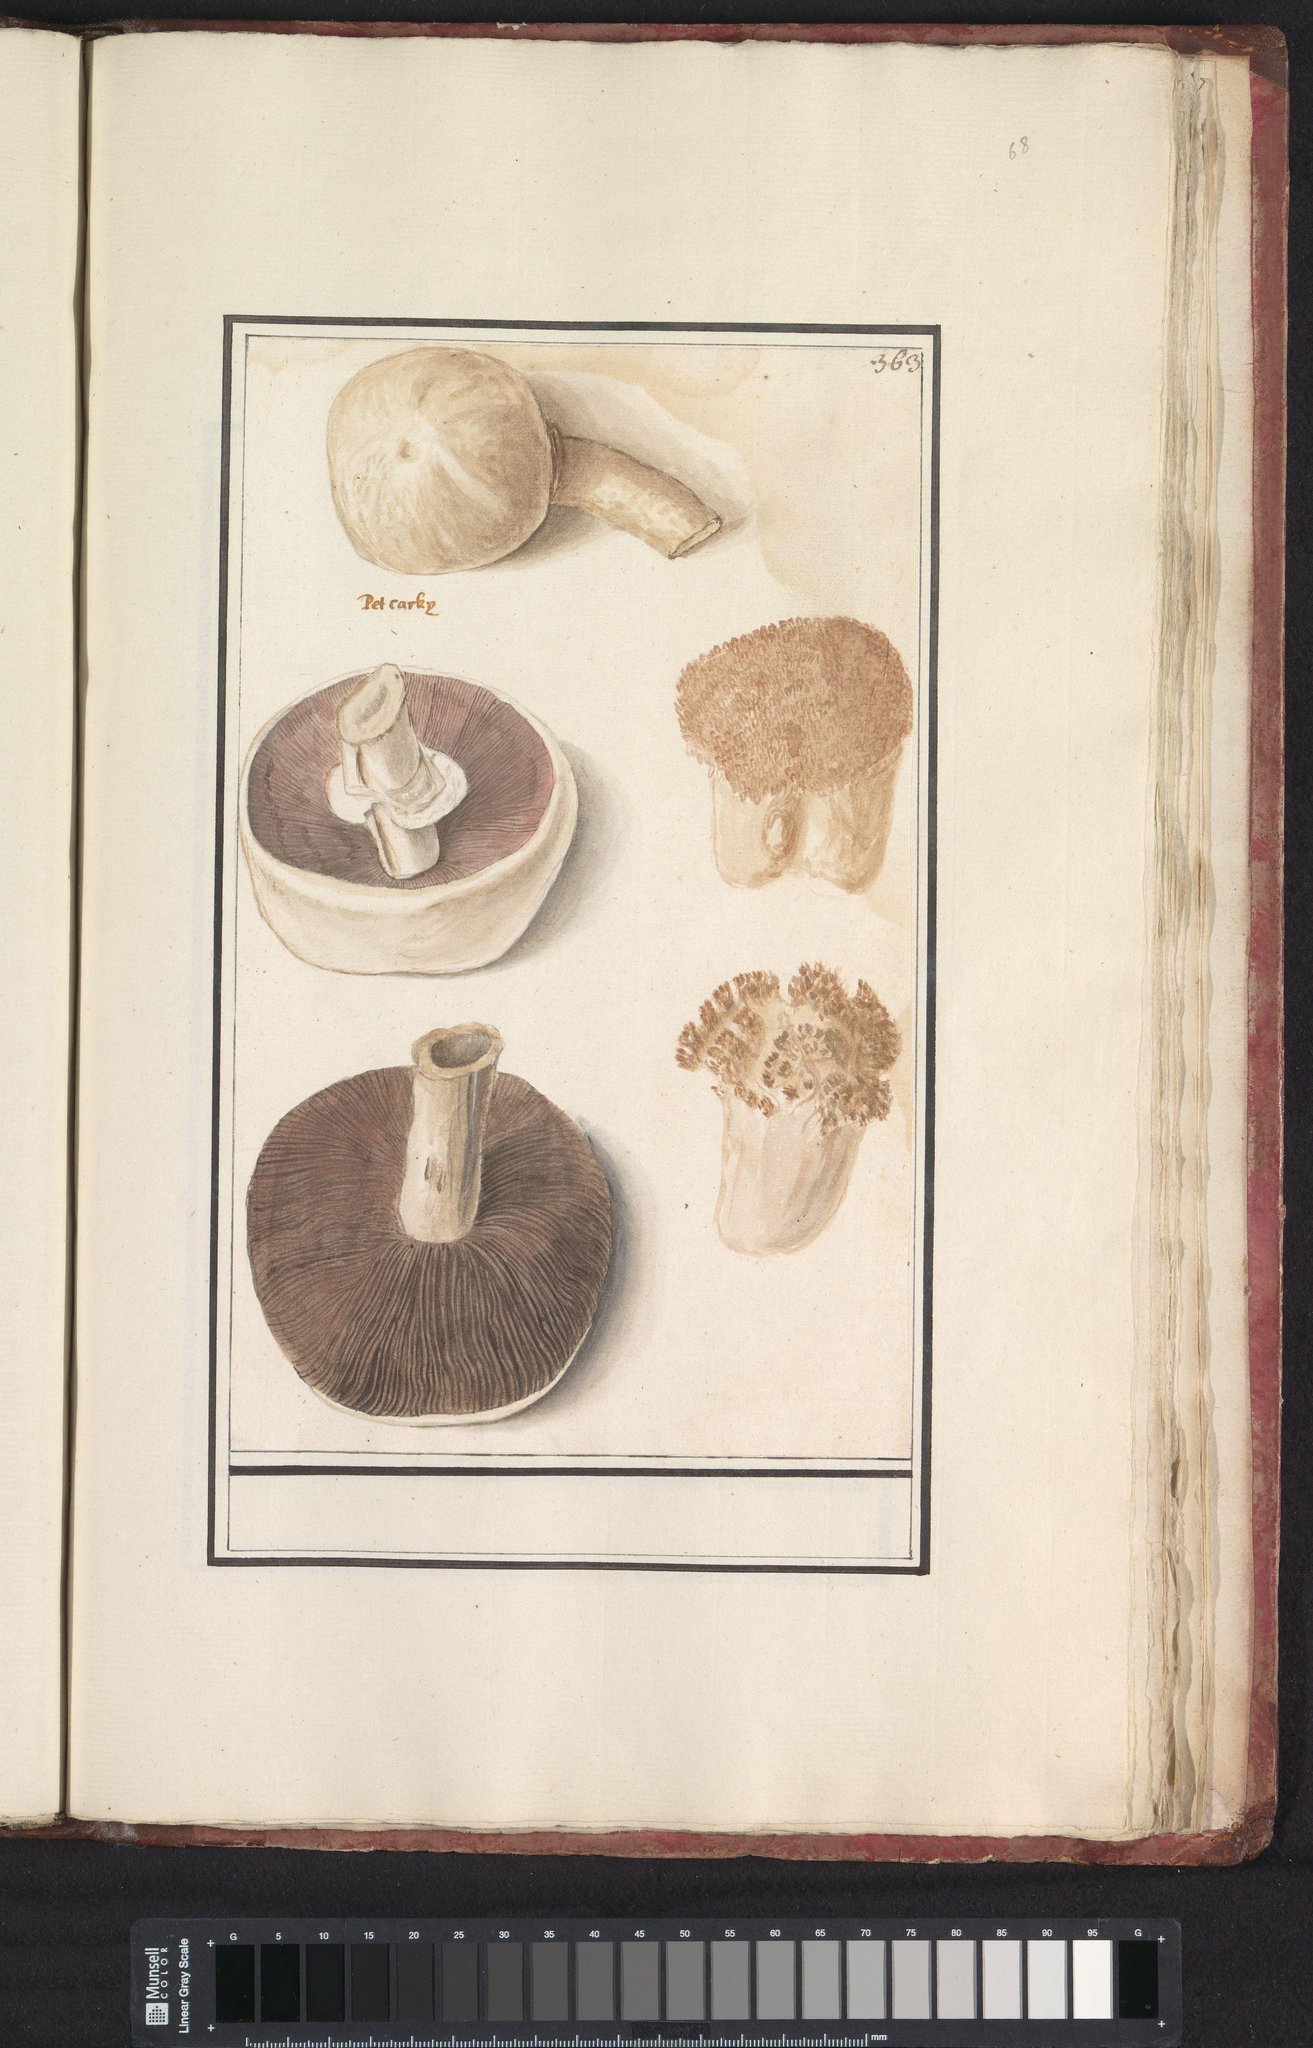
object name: drawing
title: Gewone weidechampignon (Agaricus campestris)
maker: anselmus boëtius de boodt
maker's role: draughtsman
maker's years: 1550-1632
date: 1596-1610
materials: chalk, paint, ink, paper, watercolor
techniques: brush, pen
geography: prague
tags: mushrooms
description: Weidechampignons en een andere soort paddestoel. Genummerd rechtsboven: 363. Onderdeel van het vierde album met tekeningen van bloemen en paddestoelen. Elfde van twaalf albums met tekeningen van dieren, vogels en planten bekend rond 1600, gemaakt in opdracht van keizer Rudolf II. Met toelichting in Nederlands, Latijn en Frans.